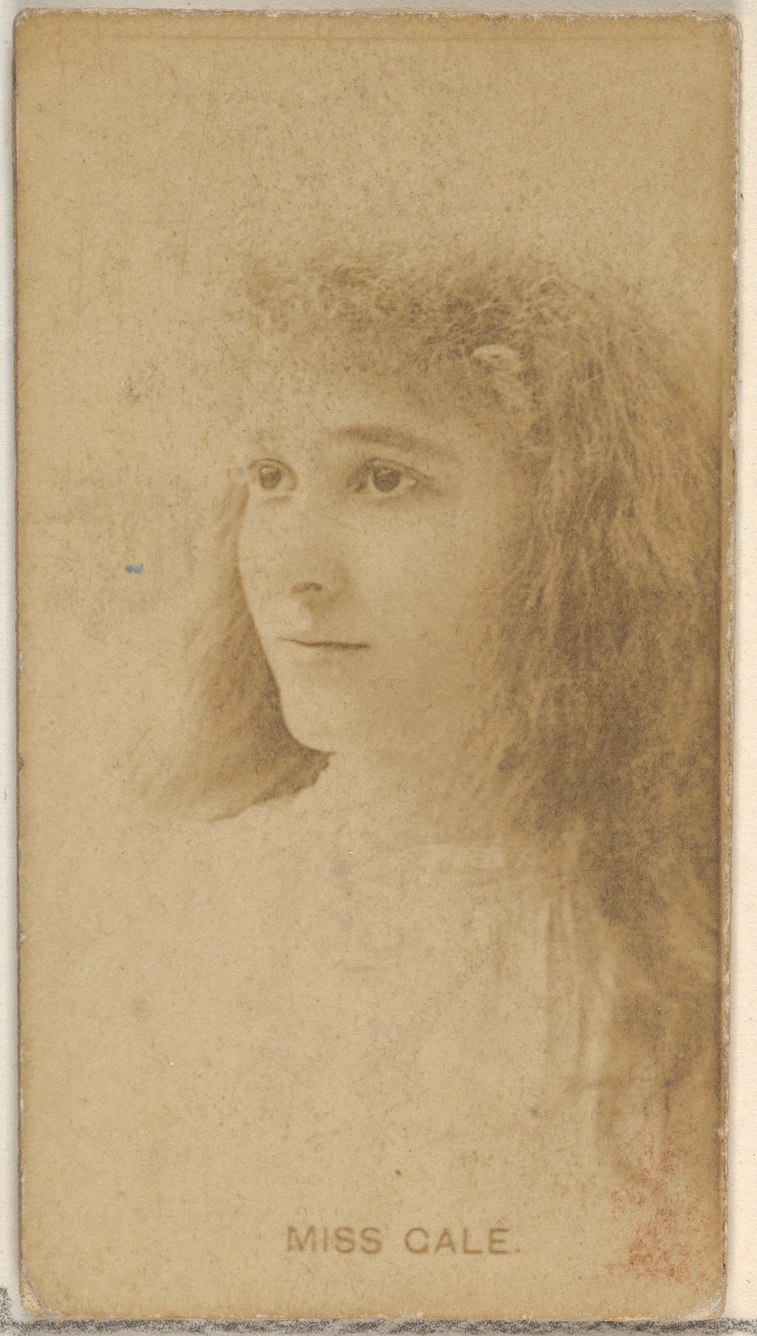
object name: photograph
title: Miss Gale, from the Actors and Actresses series (N45, Type 8) for Virginia Brights Cigarettes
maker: allen & ginter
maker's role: publisher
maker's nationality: american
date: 1888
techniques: albumen silver print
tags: portraits,women,actresses